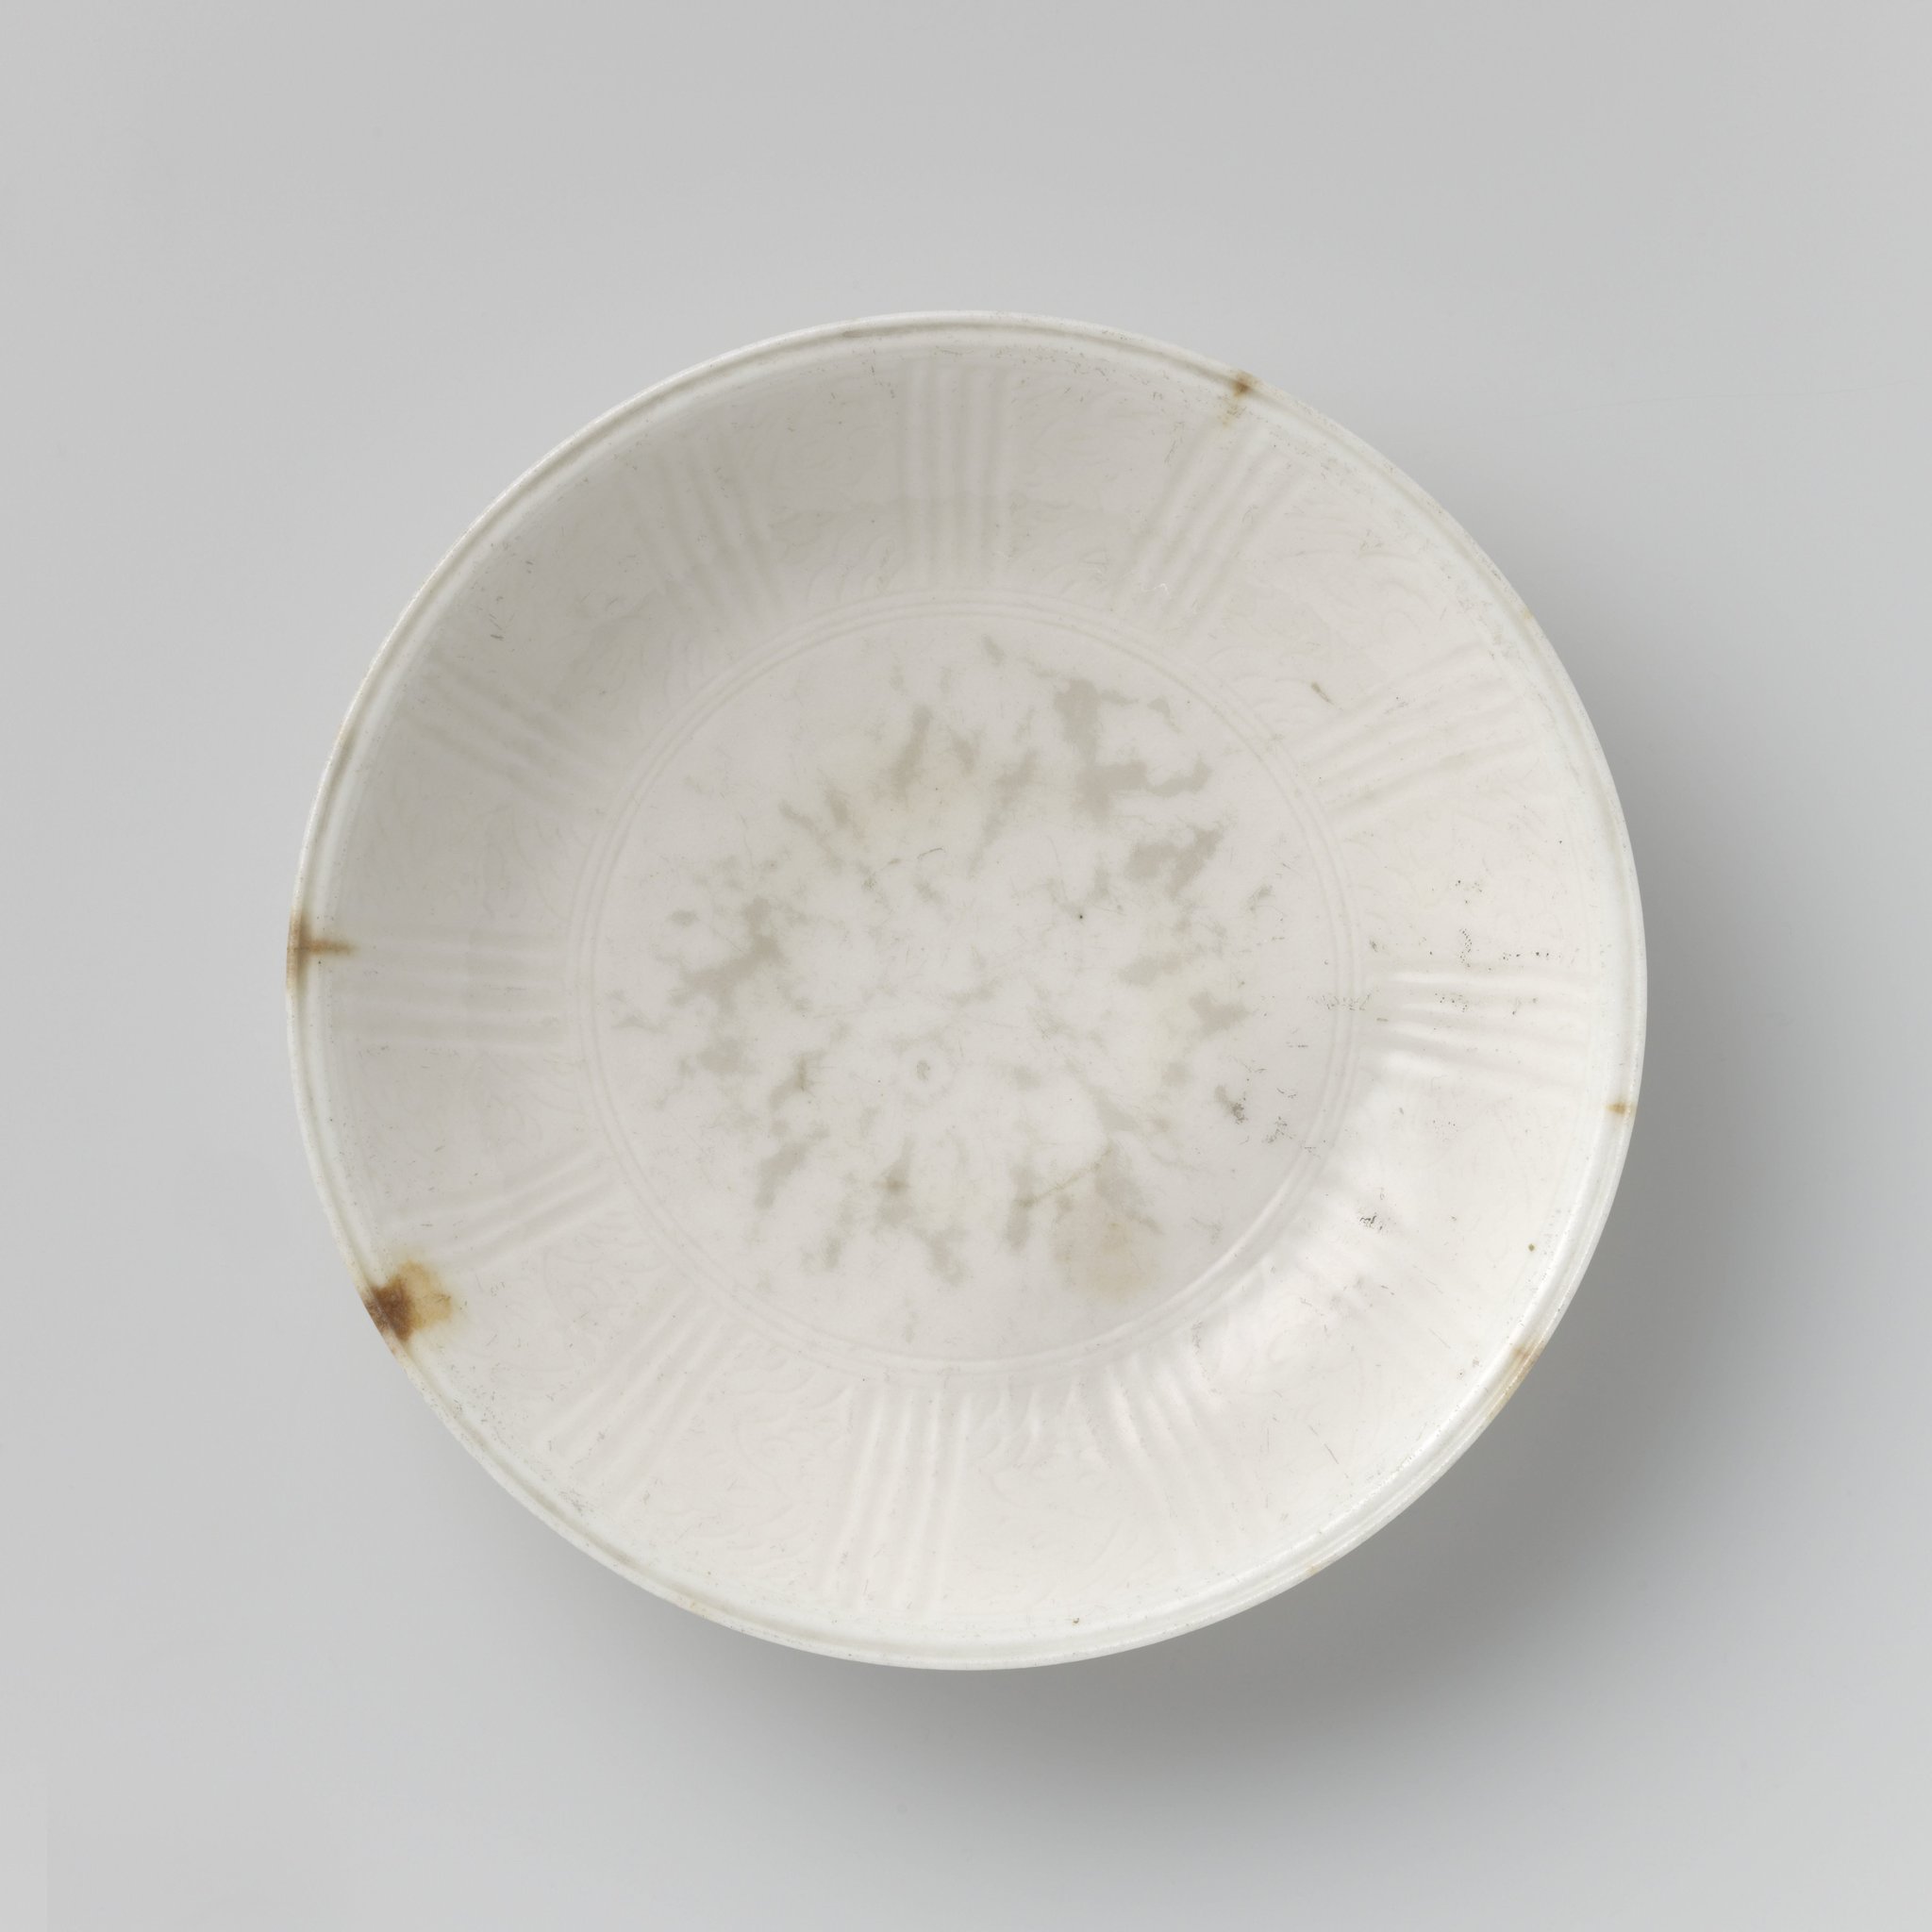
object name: dish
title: Saucer-dish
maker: Anonymous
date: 1650-1725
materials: earthenware, glaze, quartz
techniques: engraving, firing, turning, vitrification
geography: dehua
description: Schaal van kwarts-fritgoed, bedekt met een wit tinglazuur. De voorzijde van de schotel met een ingegrift medaillon op de bodem en vakdecoratie op de wand, gescheiden door vier lijnen; in de vakken ranken en vier evenwijdige lijnen. Bruine vlekken.